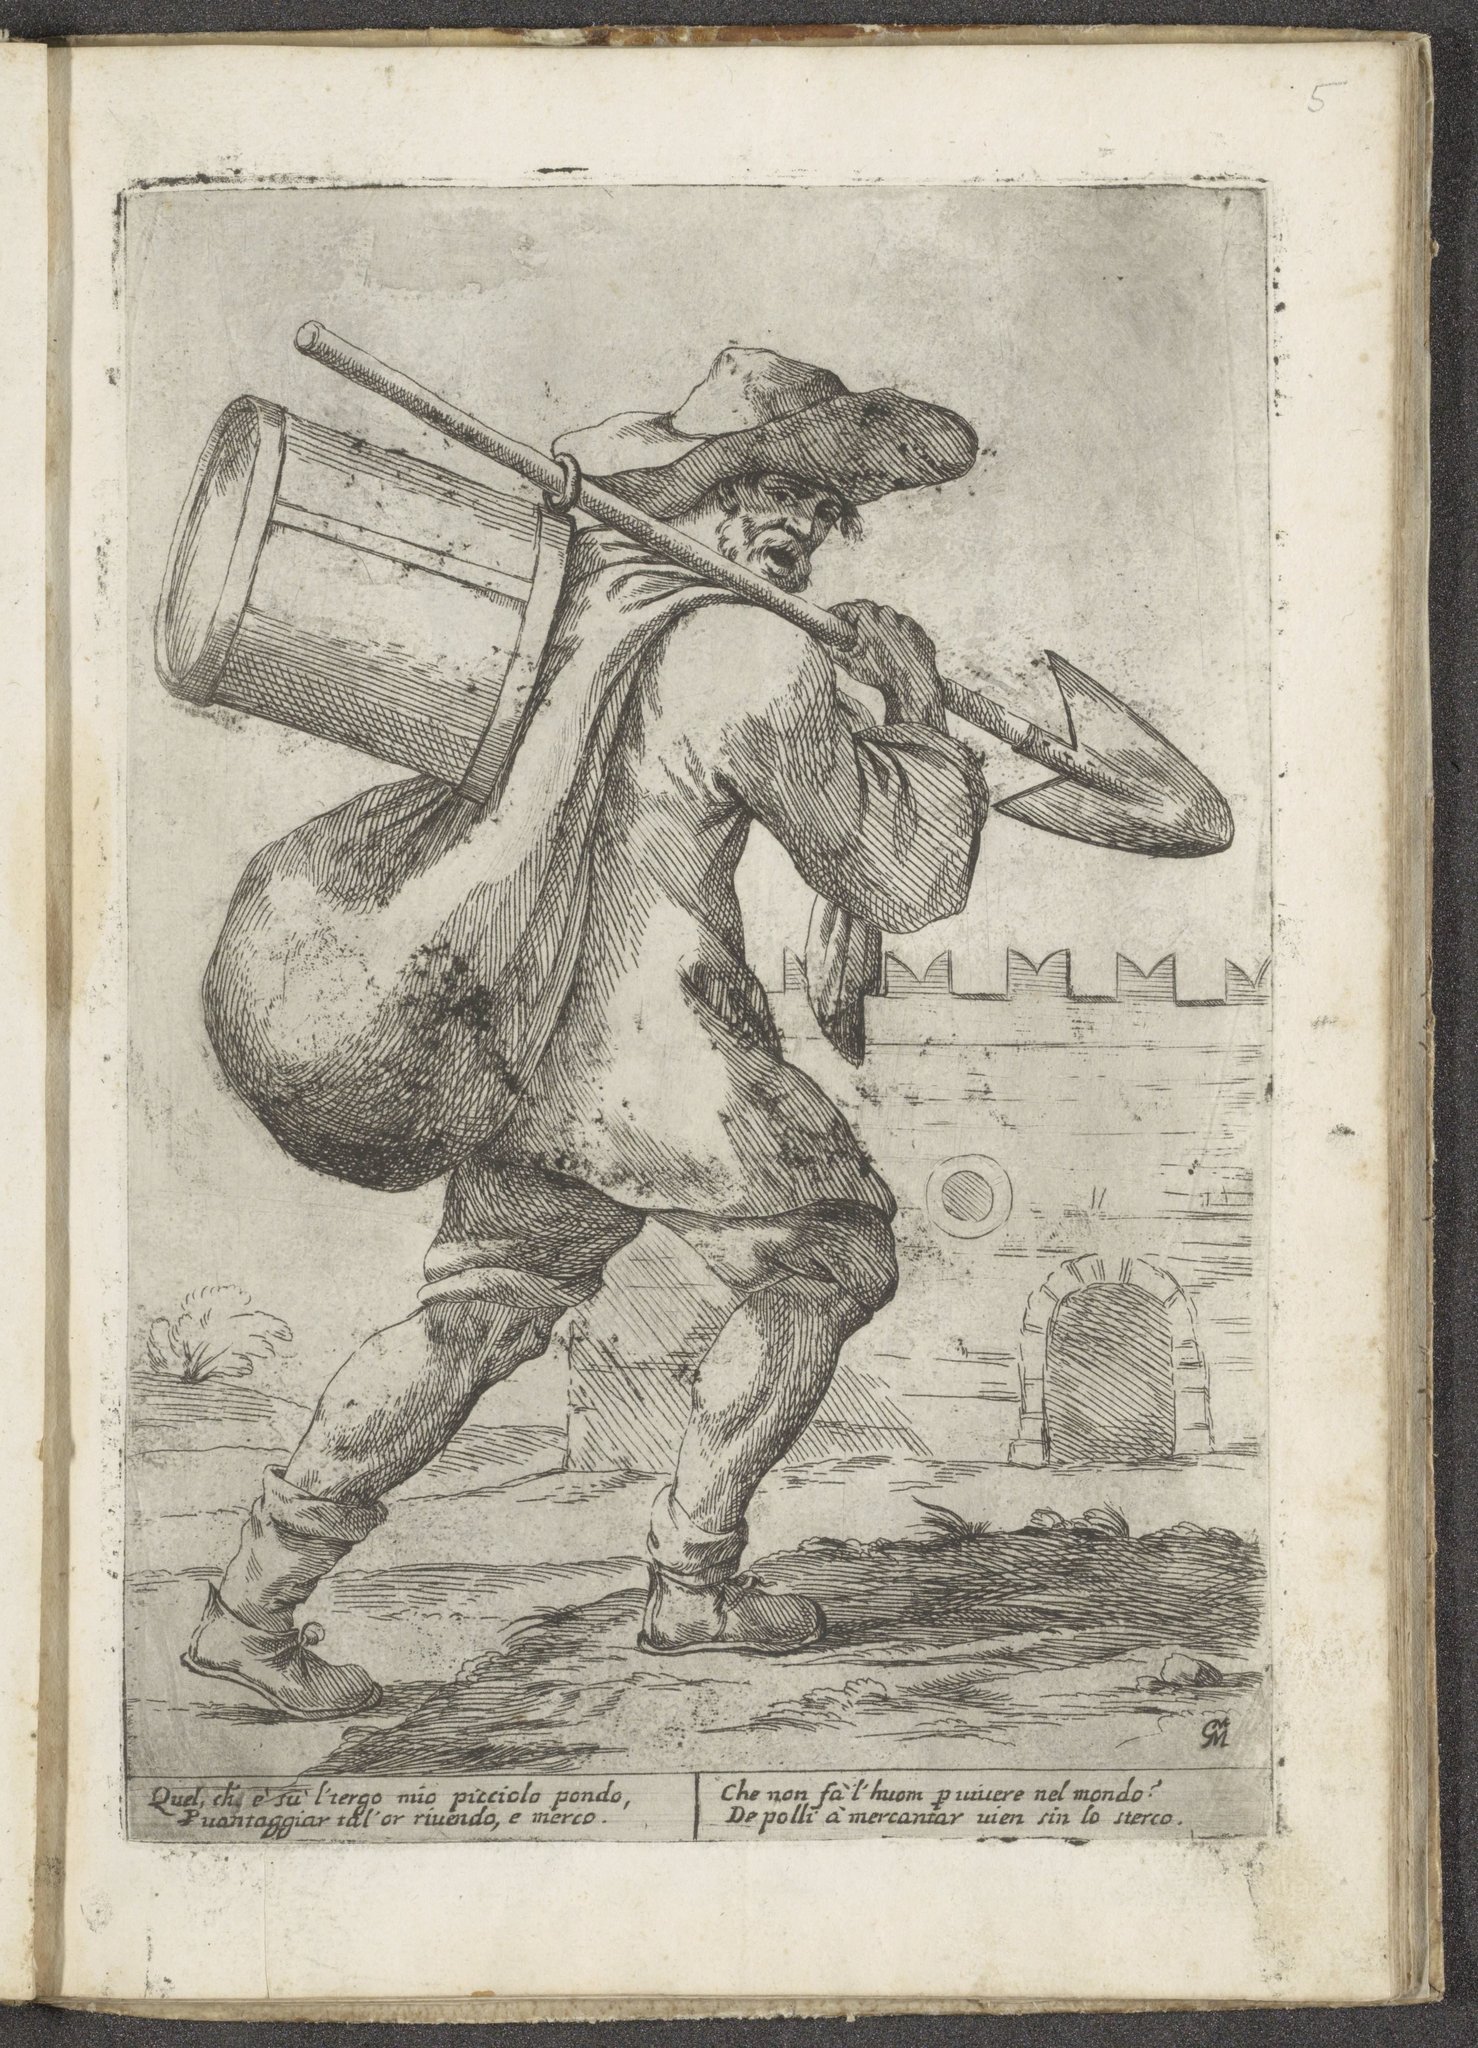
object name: album leaf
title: L'Arti Per Via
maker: giuseppe maria mitelli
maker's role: draughtsman, painter, print maker, publisher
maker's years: 1634-1718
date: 1660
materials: paper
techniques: etching, intaglio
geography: bologna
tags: animals (+ excrement, dung of animal(s)), carrying something in basket, bag, rucksack, etc., street-trader, 'cris de paris', cries of london, etc.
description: Een verkoper van kippenmest met een zak op zijn rug en een spade over de schouder waaraan een houten emmer hangt. Op de achtergrond een stadsmuur. Italiaans vers in ondermarge. De prent maakt deel uit van een album.